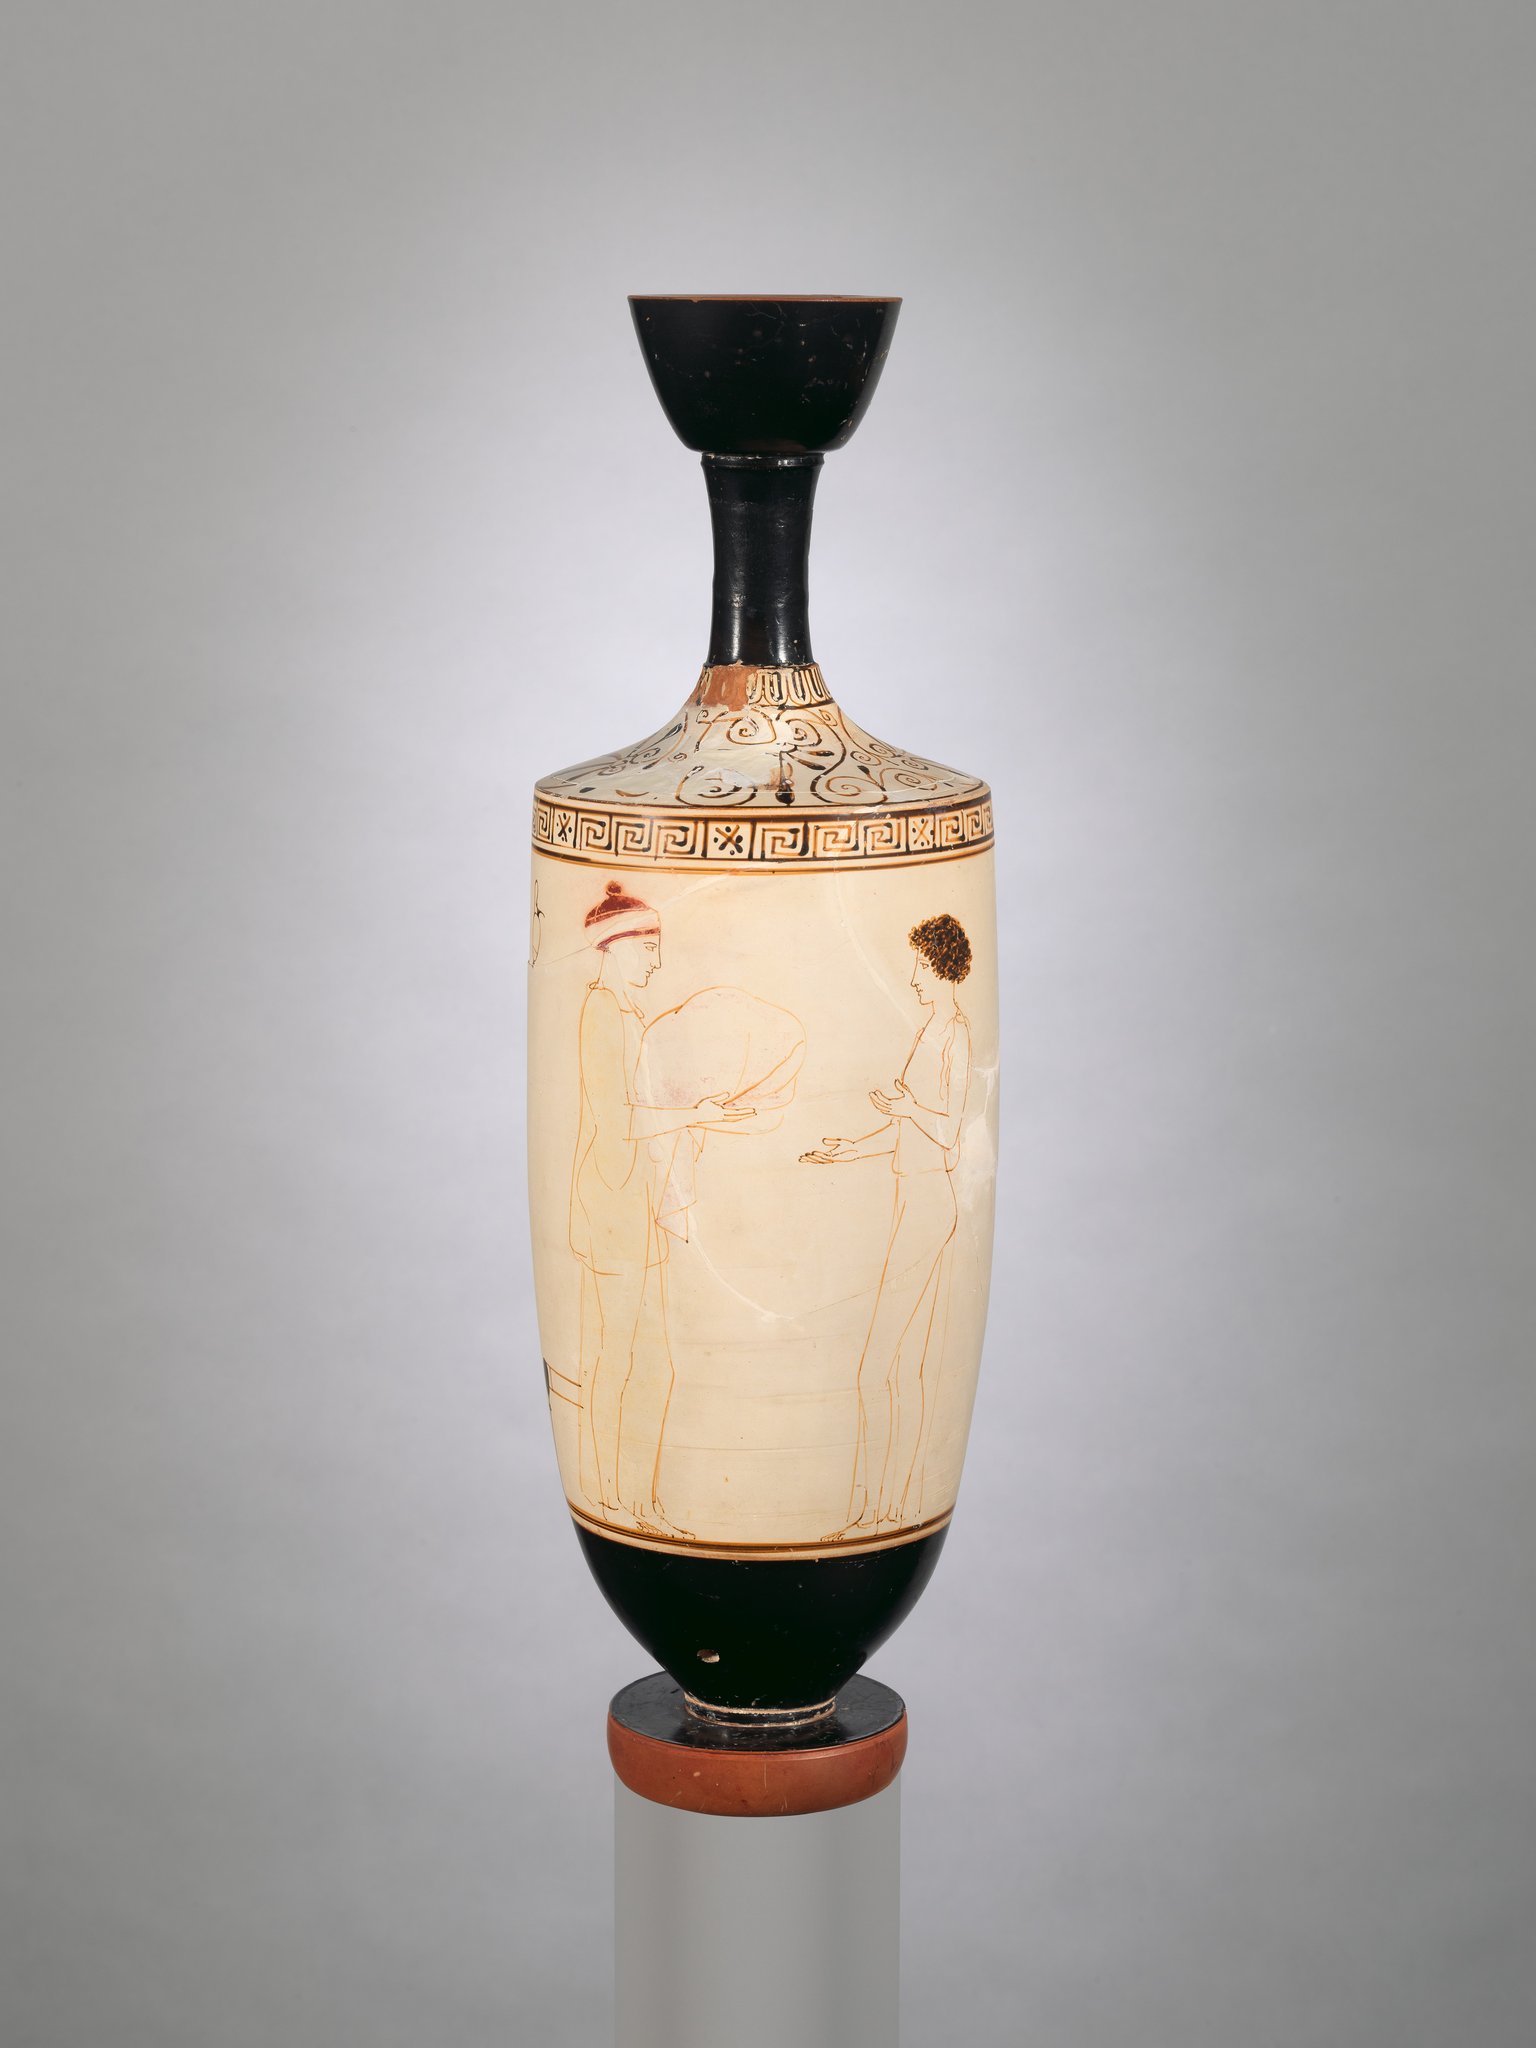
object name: lekythos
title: Terracotta lekythos (oil flask)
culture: greek, attic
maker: achilles painter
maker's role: artist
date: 440 BCE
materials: terracotta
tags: women